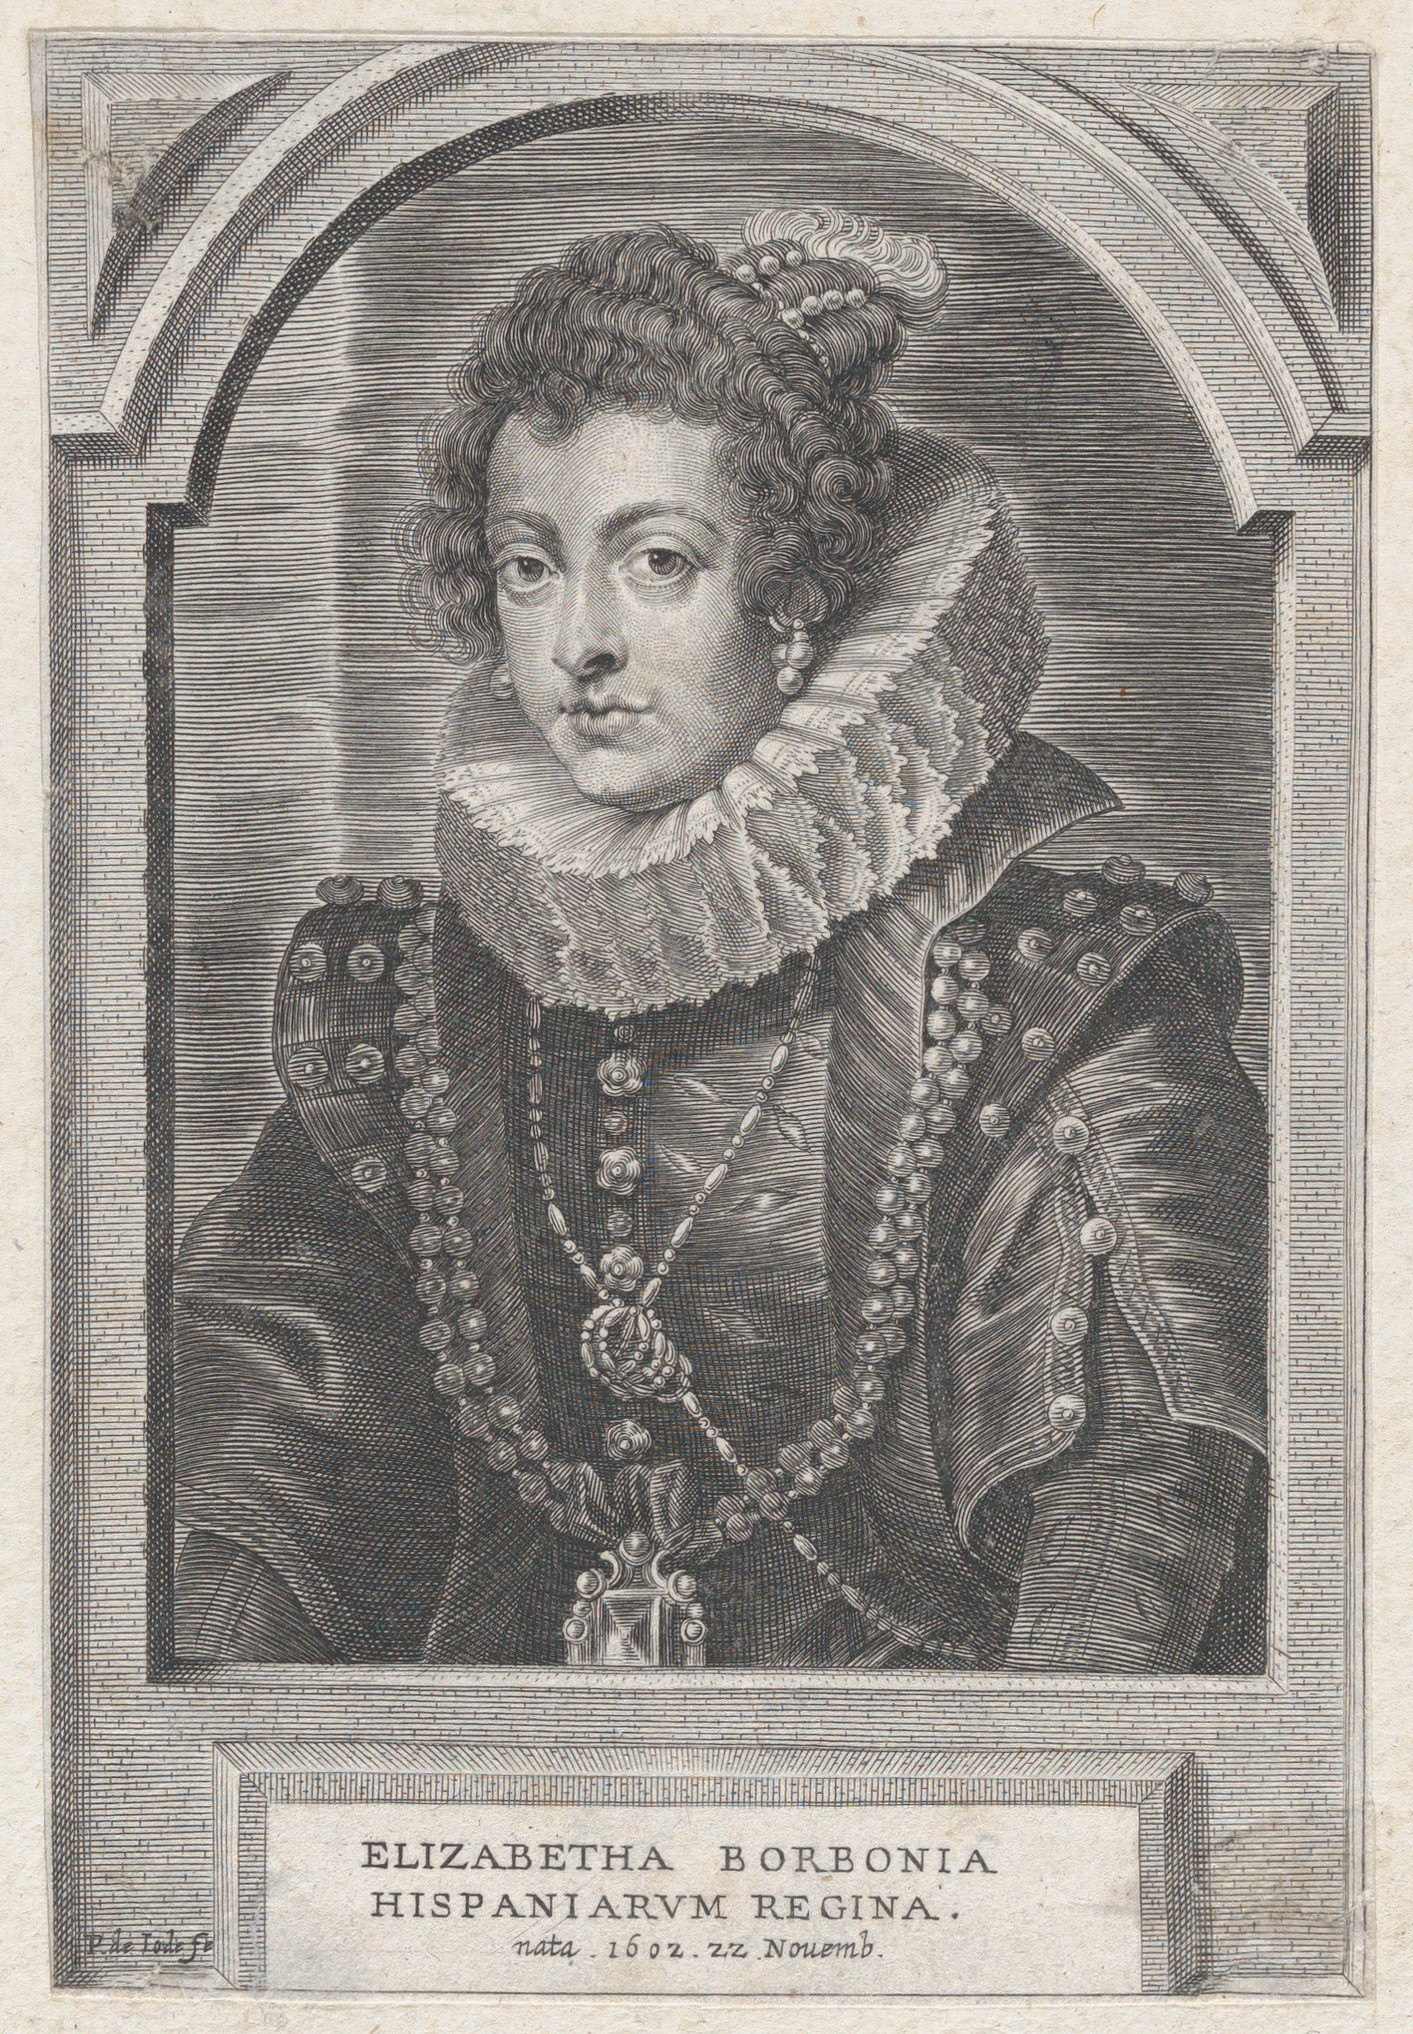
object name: print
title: Portrait of Elisabeth of Bourbon, Queen of Spain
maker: pieter de jode (ii)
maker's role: artist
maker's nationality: flemish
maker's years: 1606-1674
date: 1632-1644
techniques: engraving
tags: queens,portraits,women